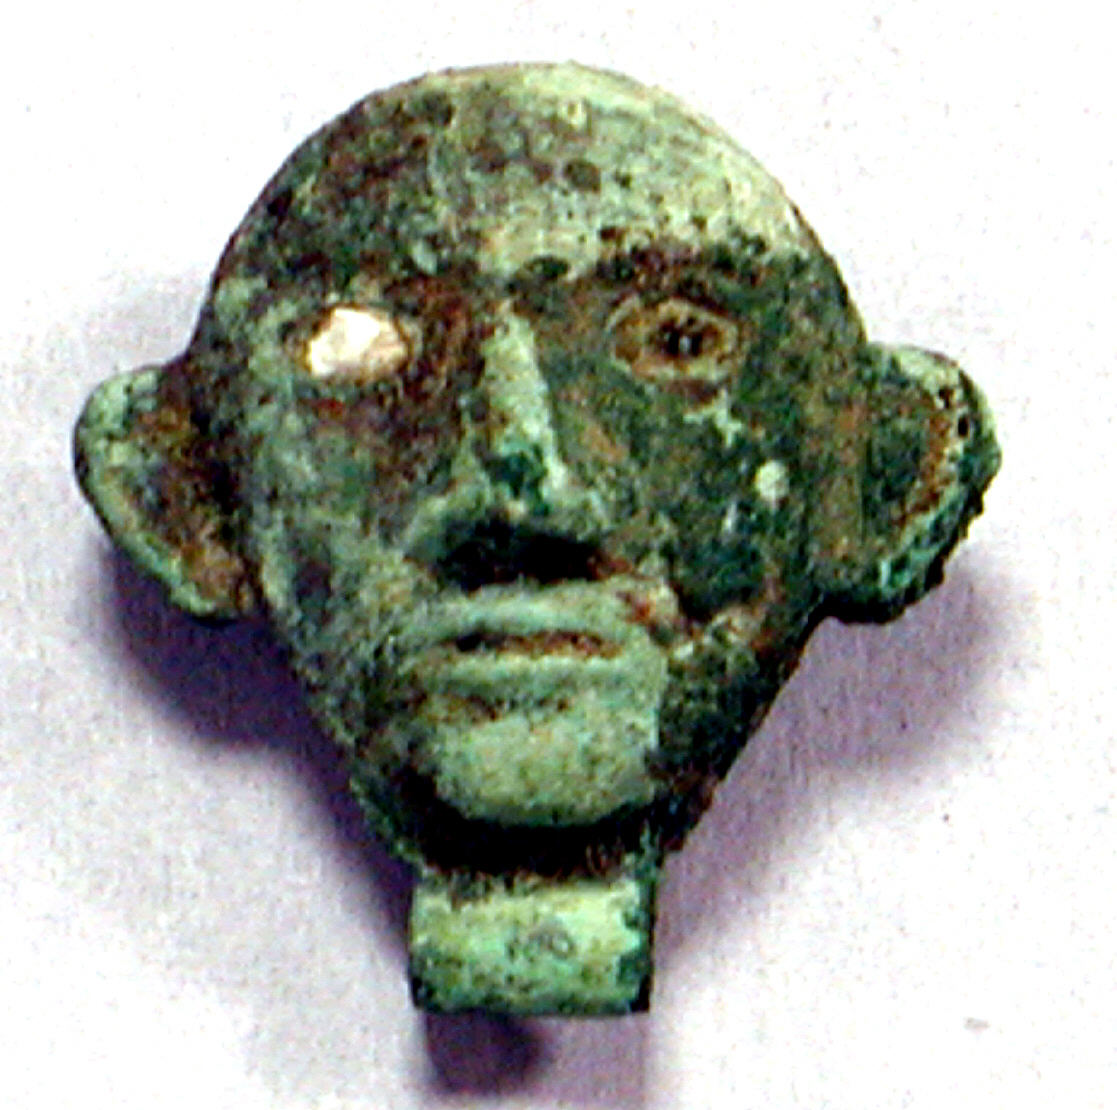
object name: tweezer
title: Copper Tweezers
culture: moche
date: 101-700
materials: copper, shell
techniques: hammering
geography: peru